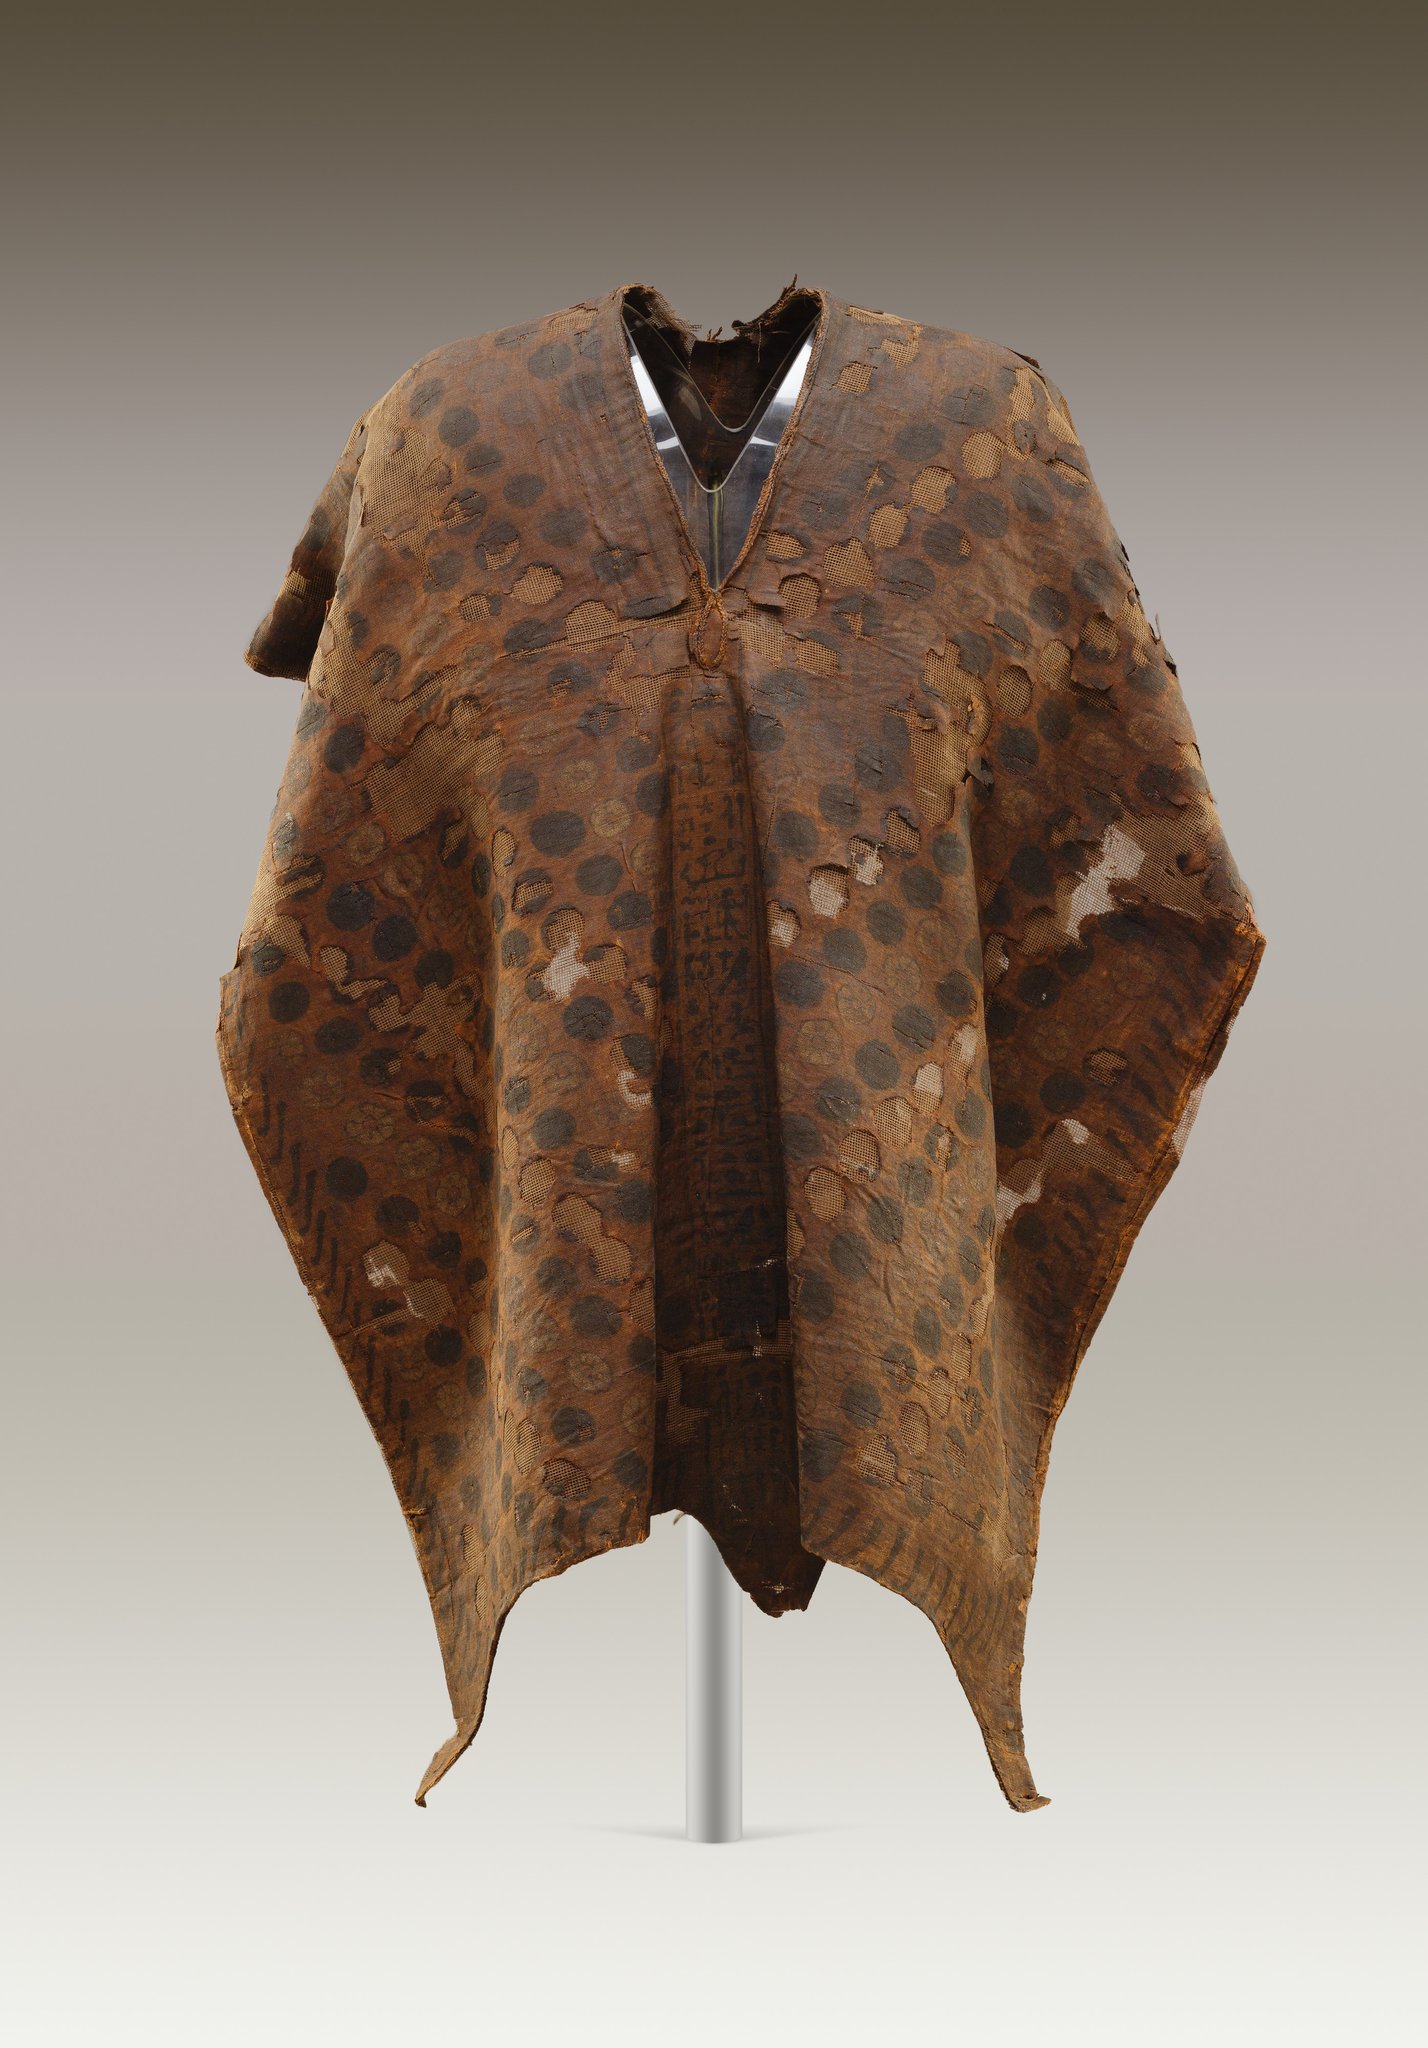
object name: robe, harnedj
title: “Leopard-skin” robe of the priest, Harnedjitef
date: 1-100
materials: linen, paint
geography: northern upper egypt